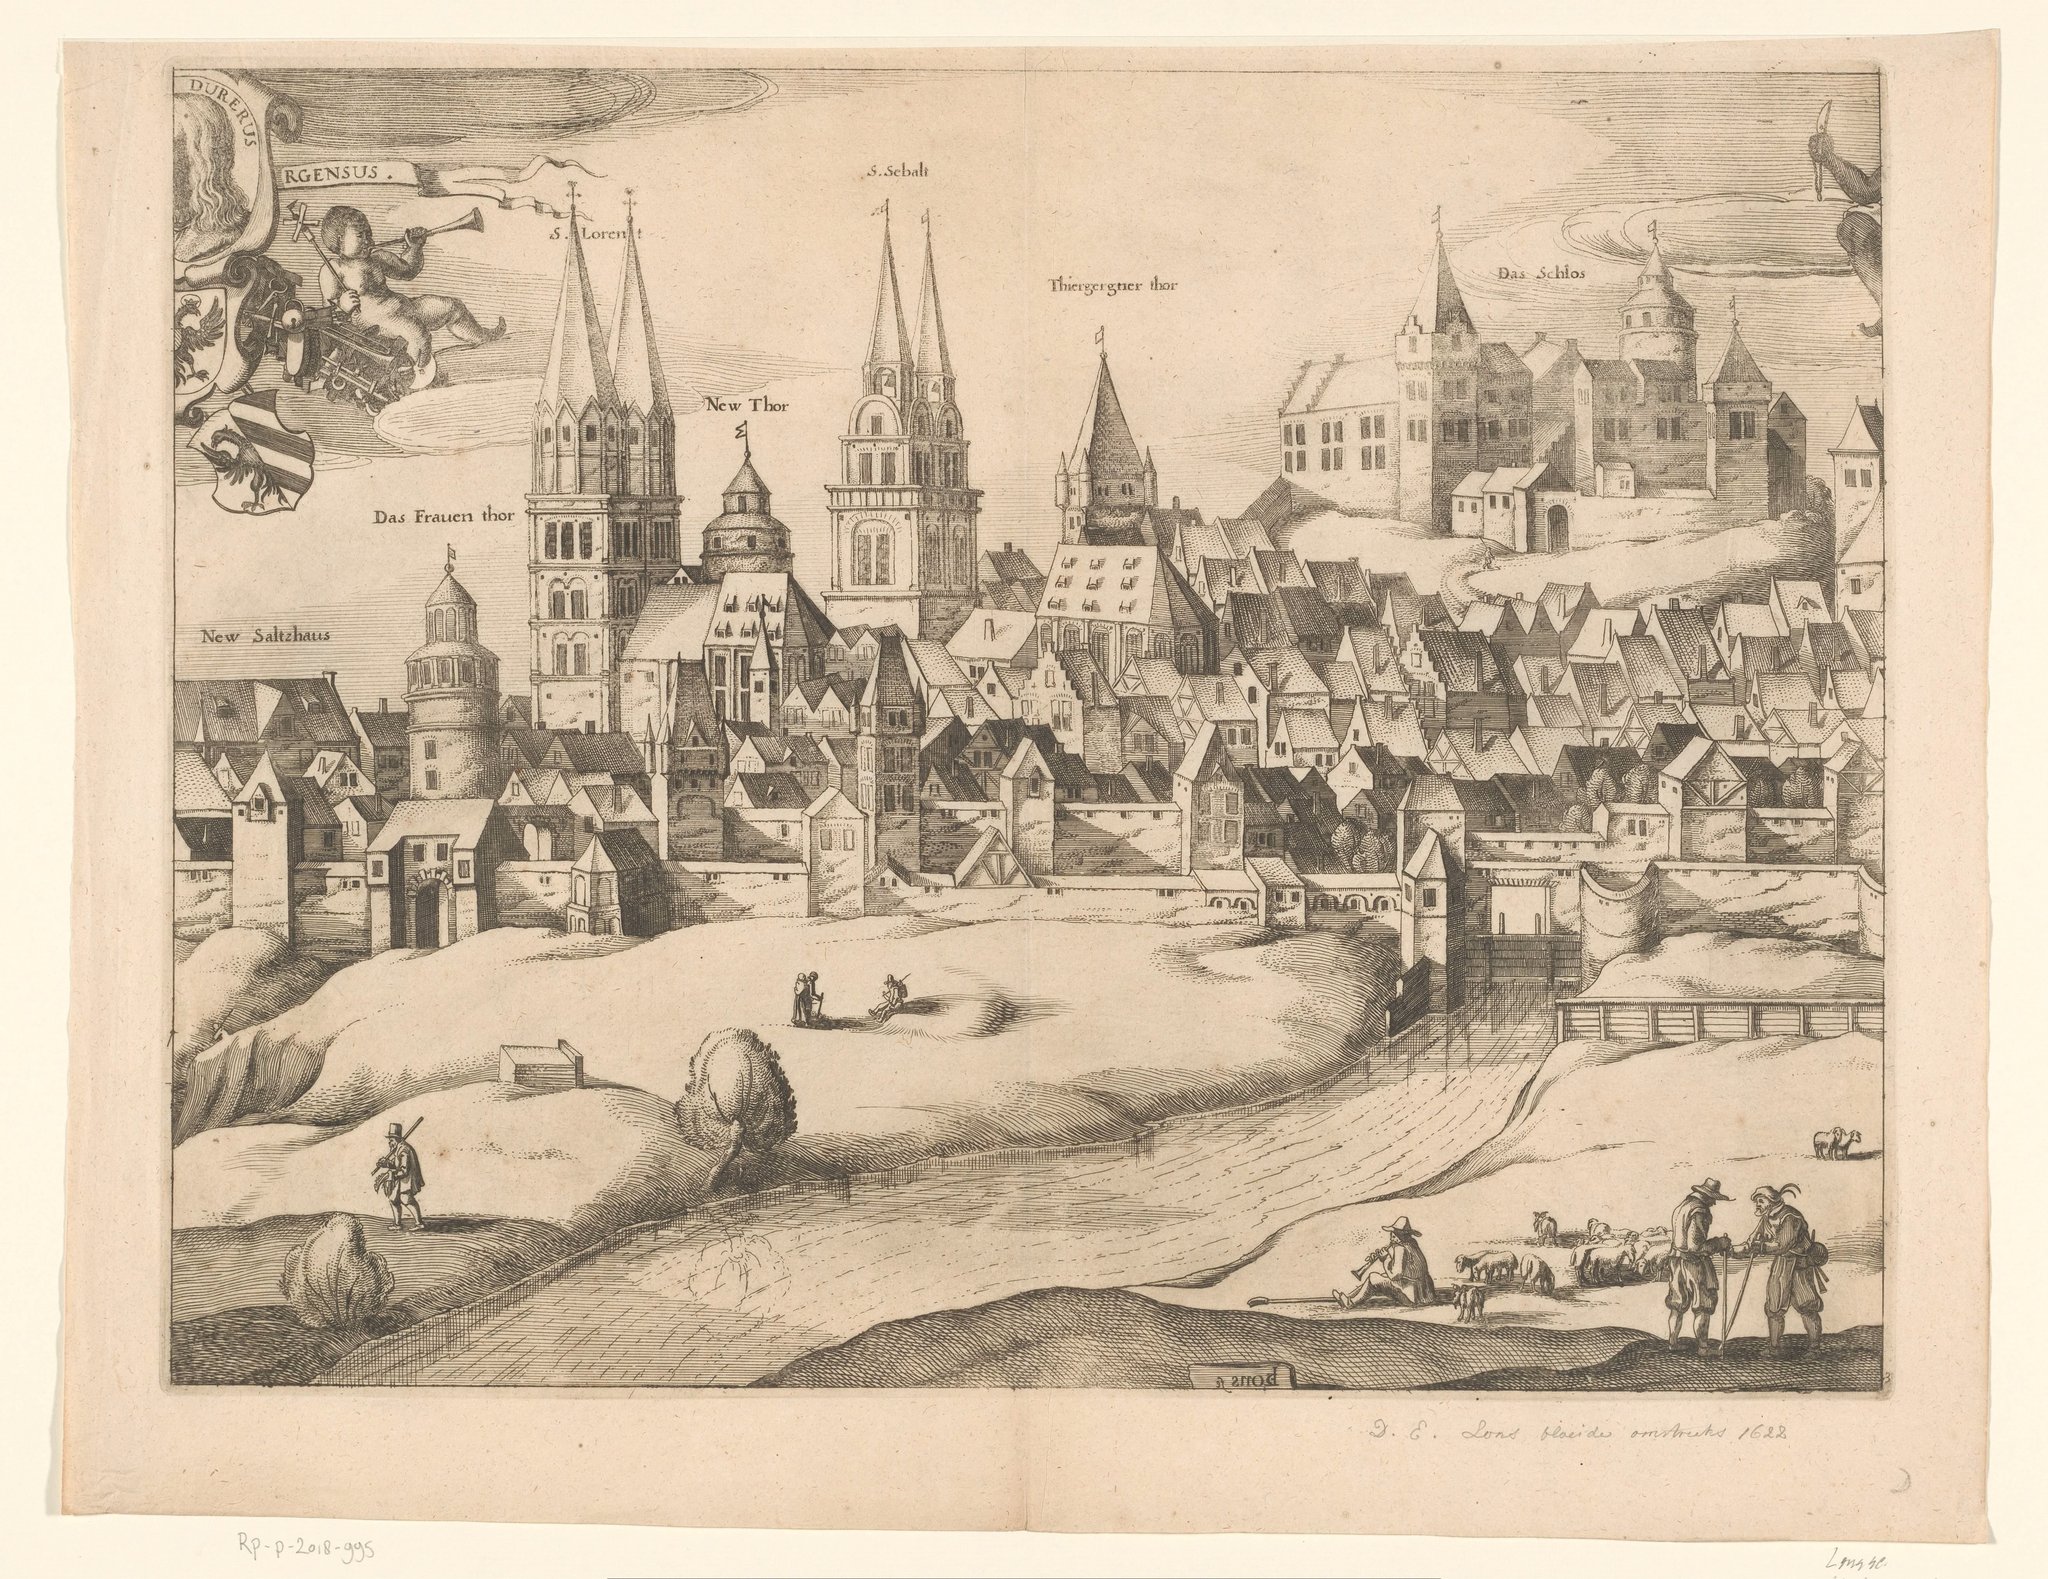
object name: print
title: Gezicht op Neurenberg (blad 3)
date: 1666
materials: paper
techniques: etching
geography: amsterdam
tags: painter, print maker, draughtsman, albrecht dürer, city-view, and landscape with man-made constructions, castle, herding, herdsman, herdswoman, shepherd, shepherdess, cowherd, etc., church (exterior)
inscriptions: collector's mark: Lugt 2228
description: Gezicht op de Duitse stad Neurenberg met verschillende kerken, torens en een slot. Buiten de stadsmuren een herder met zijn kudde en aan weerszijden van de rivier wandelaars. Geheel boven een (gehalveerd) portret van Albrecht Dürer.